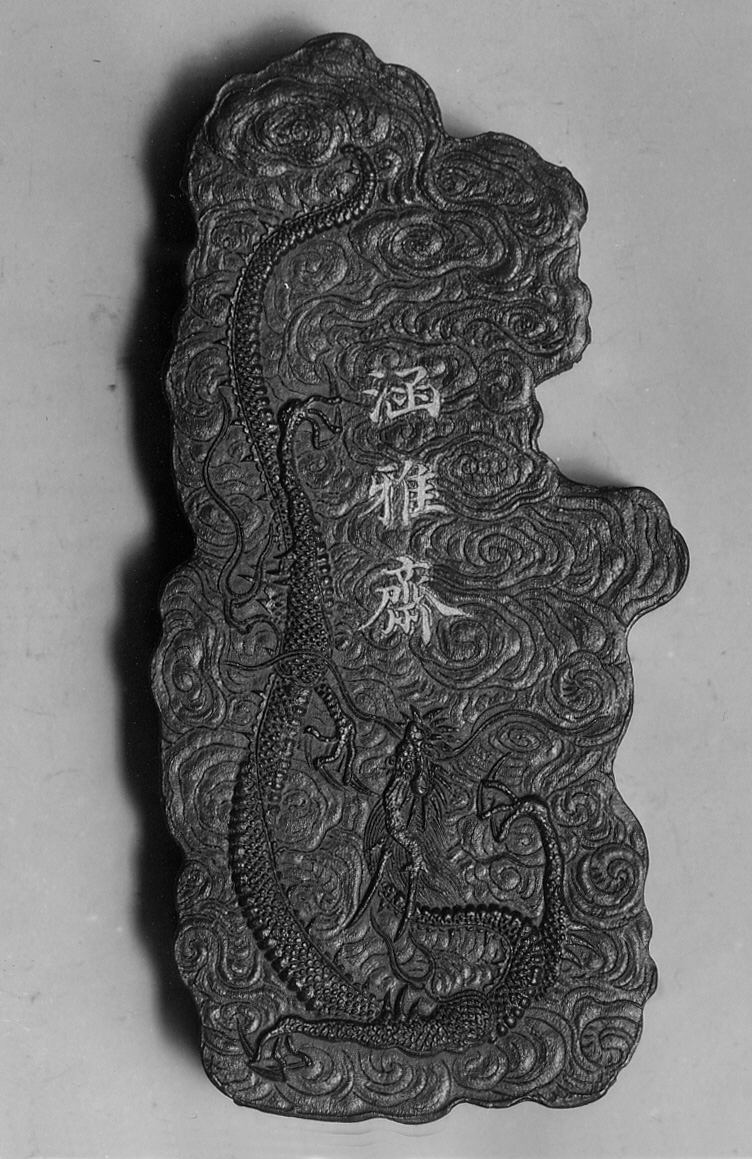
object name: ink tablet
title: Cherishing Elegance Studio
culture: chinese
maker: jian guzhai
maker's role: artist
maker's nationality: chinese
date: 1867-1933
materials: gilt, wood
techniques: bookbinding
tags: dragons